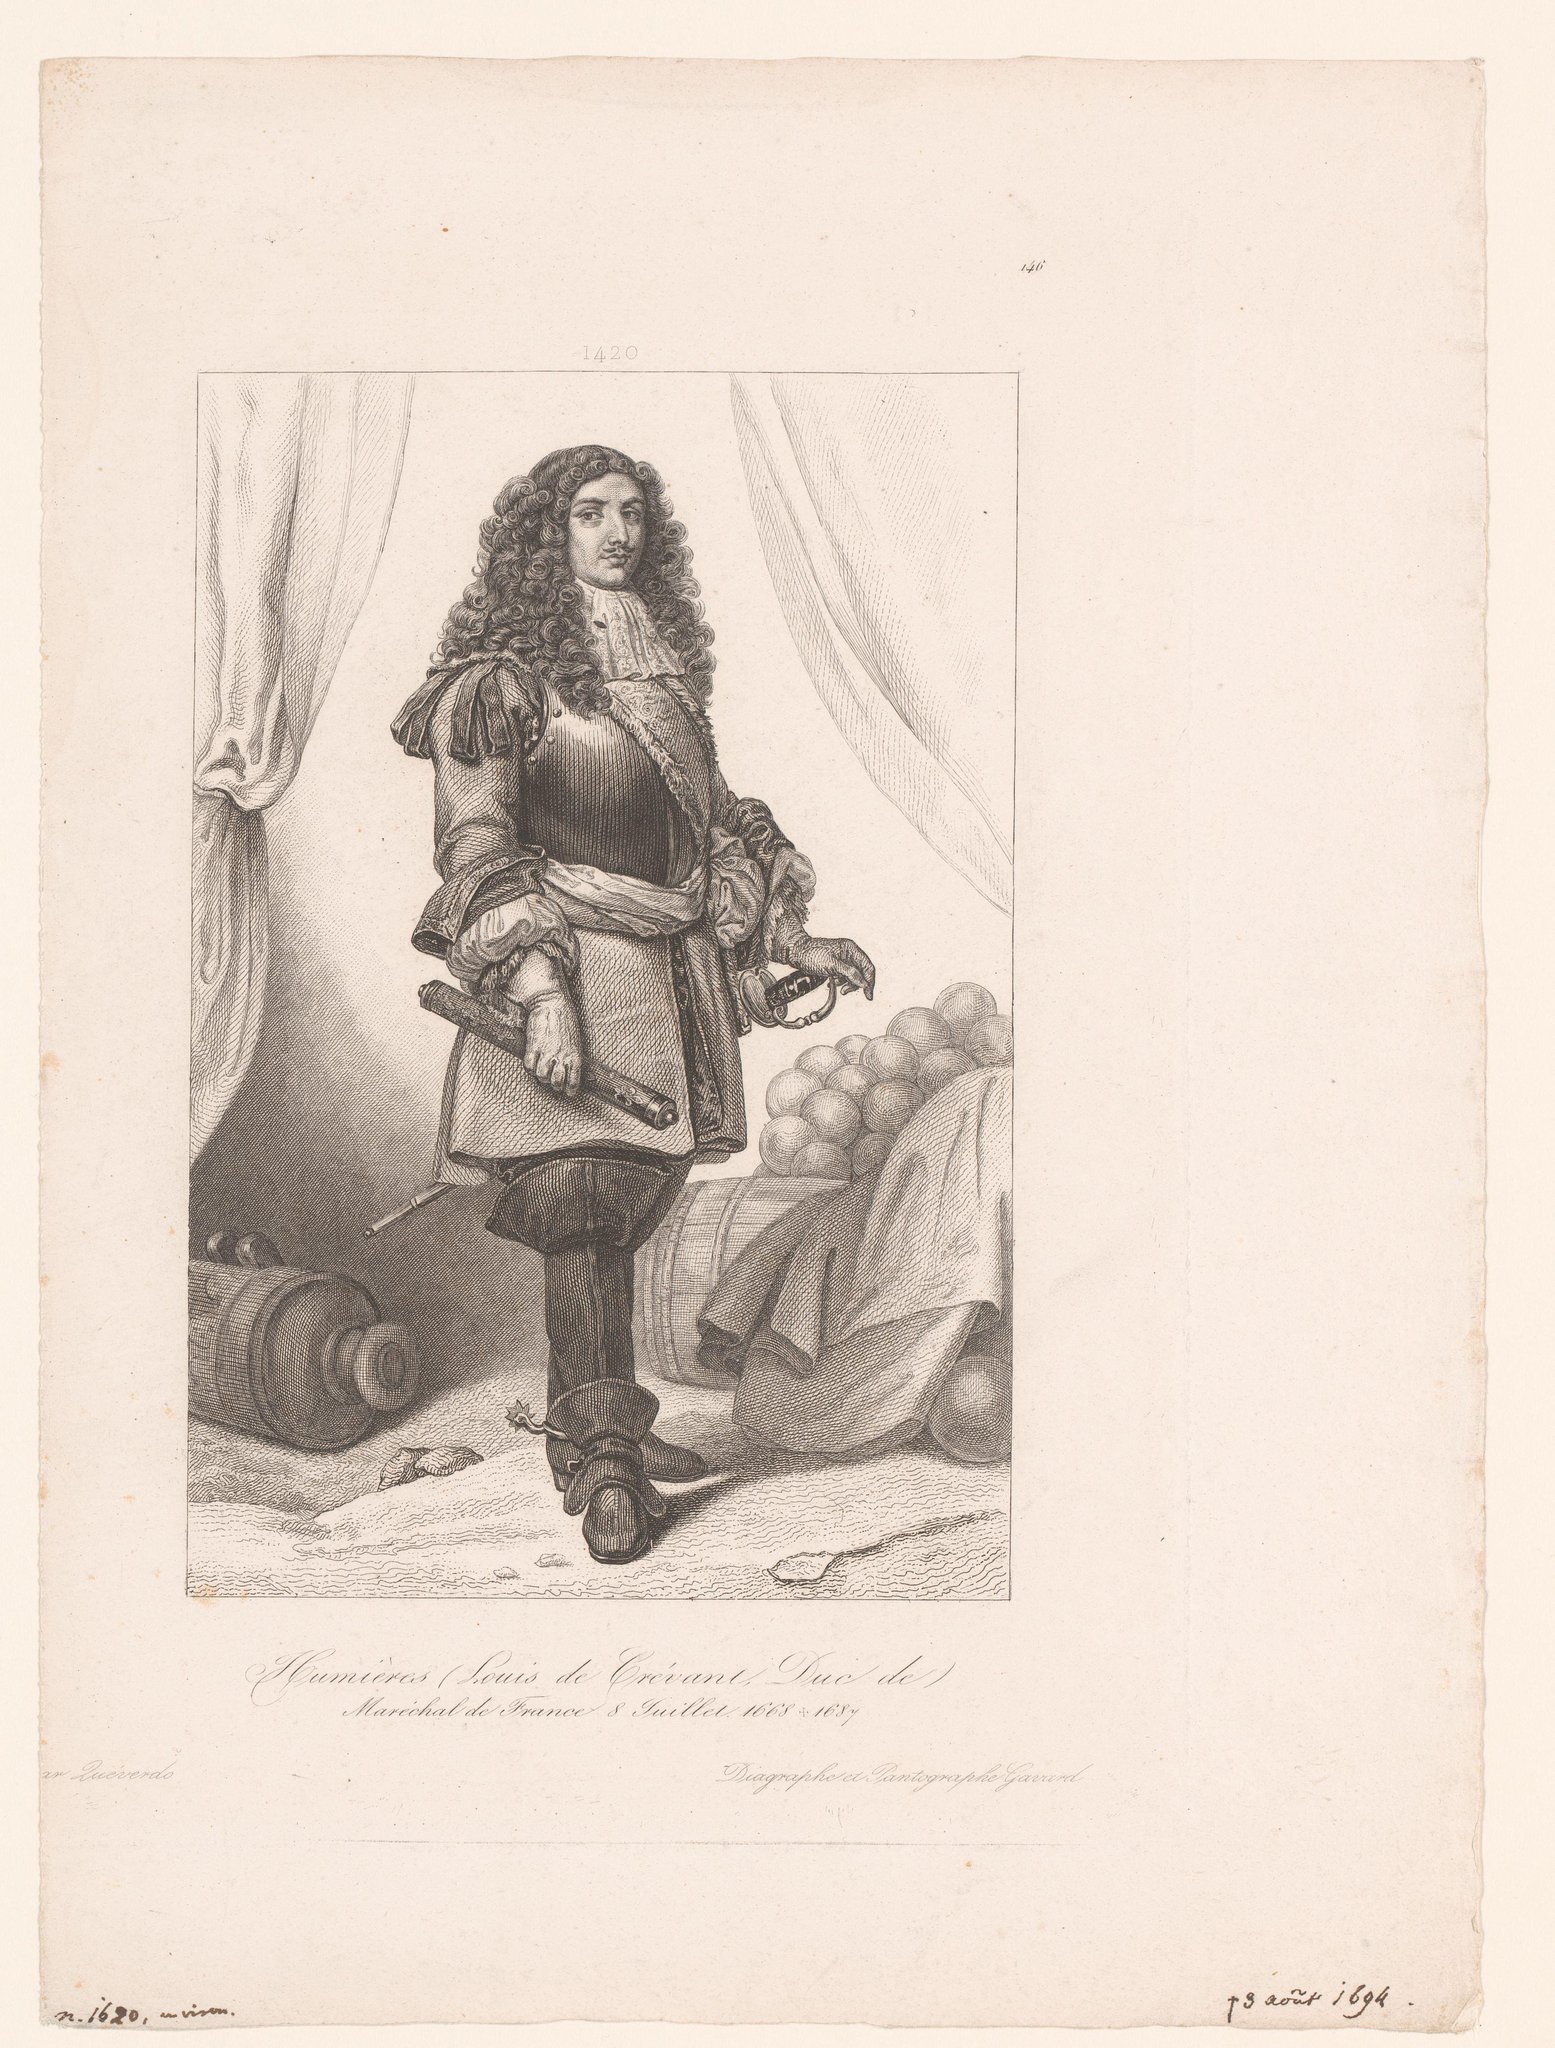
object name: print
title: Portret van Louis de Crévant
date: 1838-1841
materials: paper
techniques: etching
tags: louis de crévant (hertog van humières), commander-in-chief, general, marshal, historical persons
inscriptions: collector's mark: Lugt 2228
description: Prent uit: Galeries historiques de Versailles. Parijs: Charles Gavard, 1838-1841.